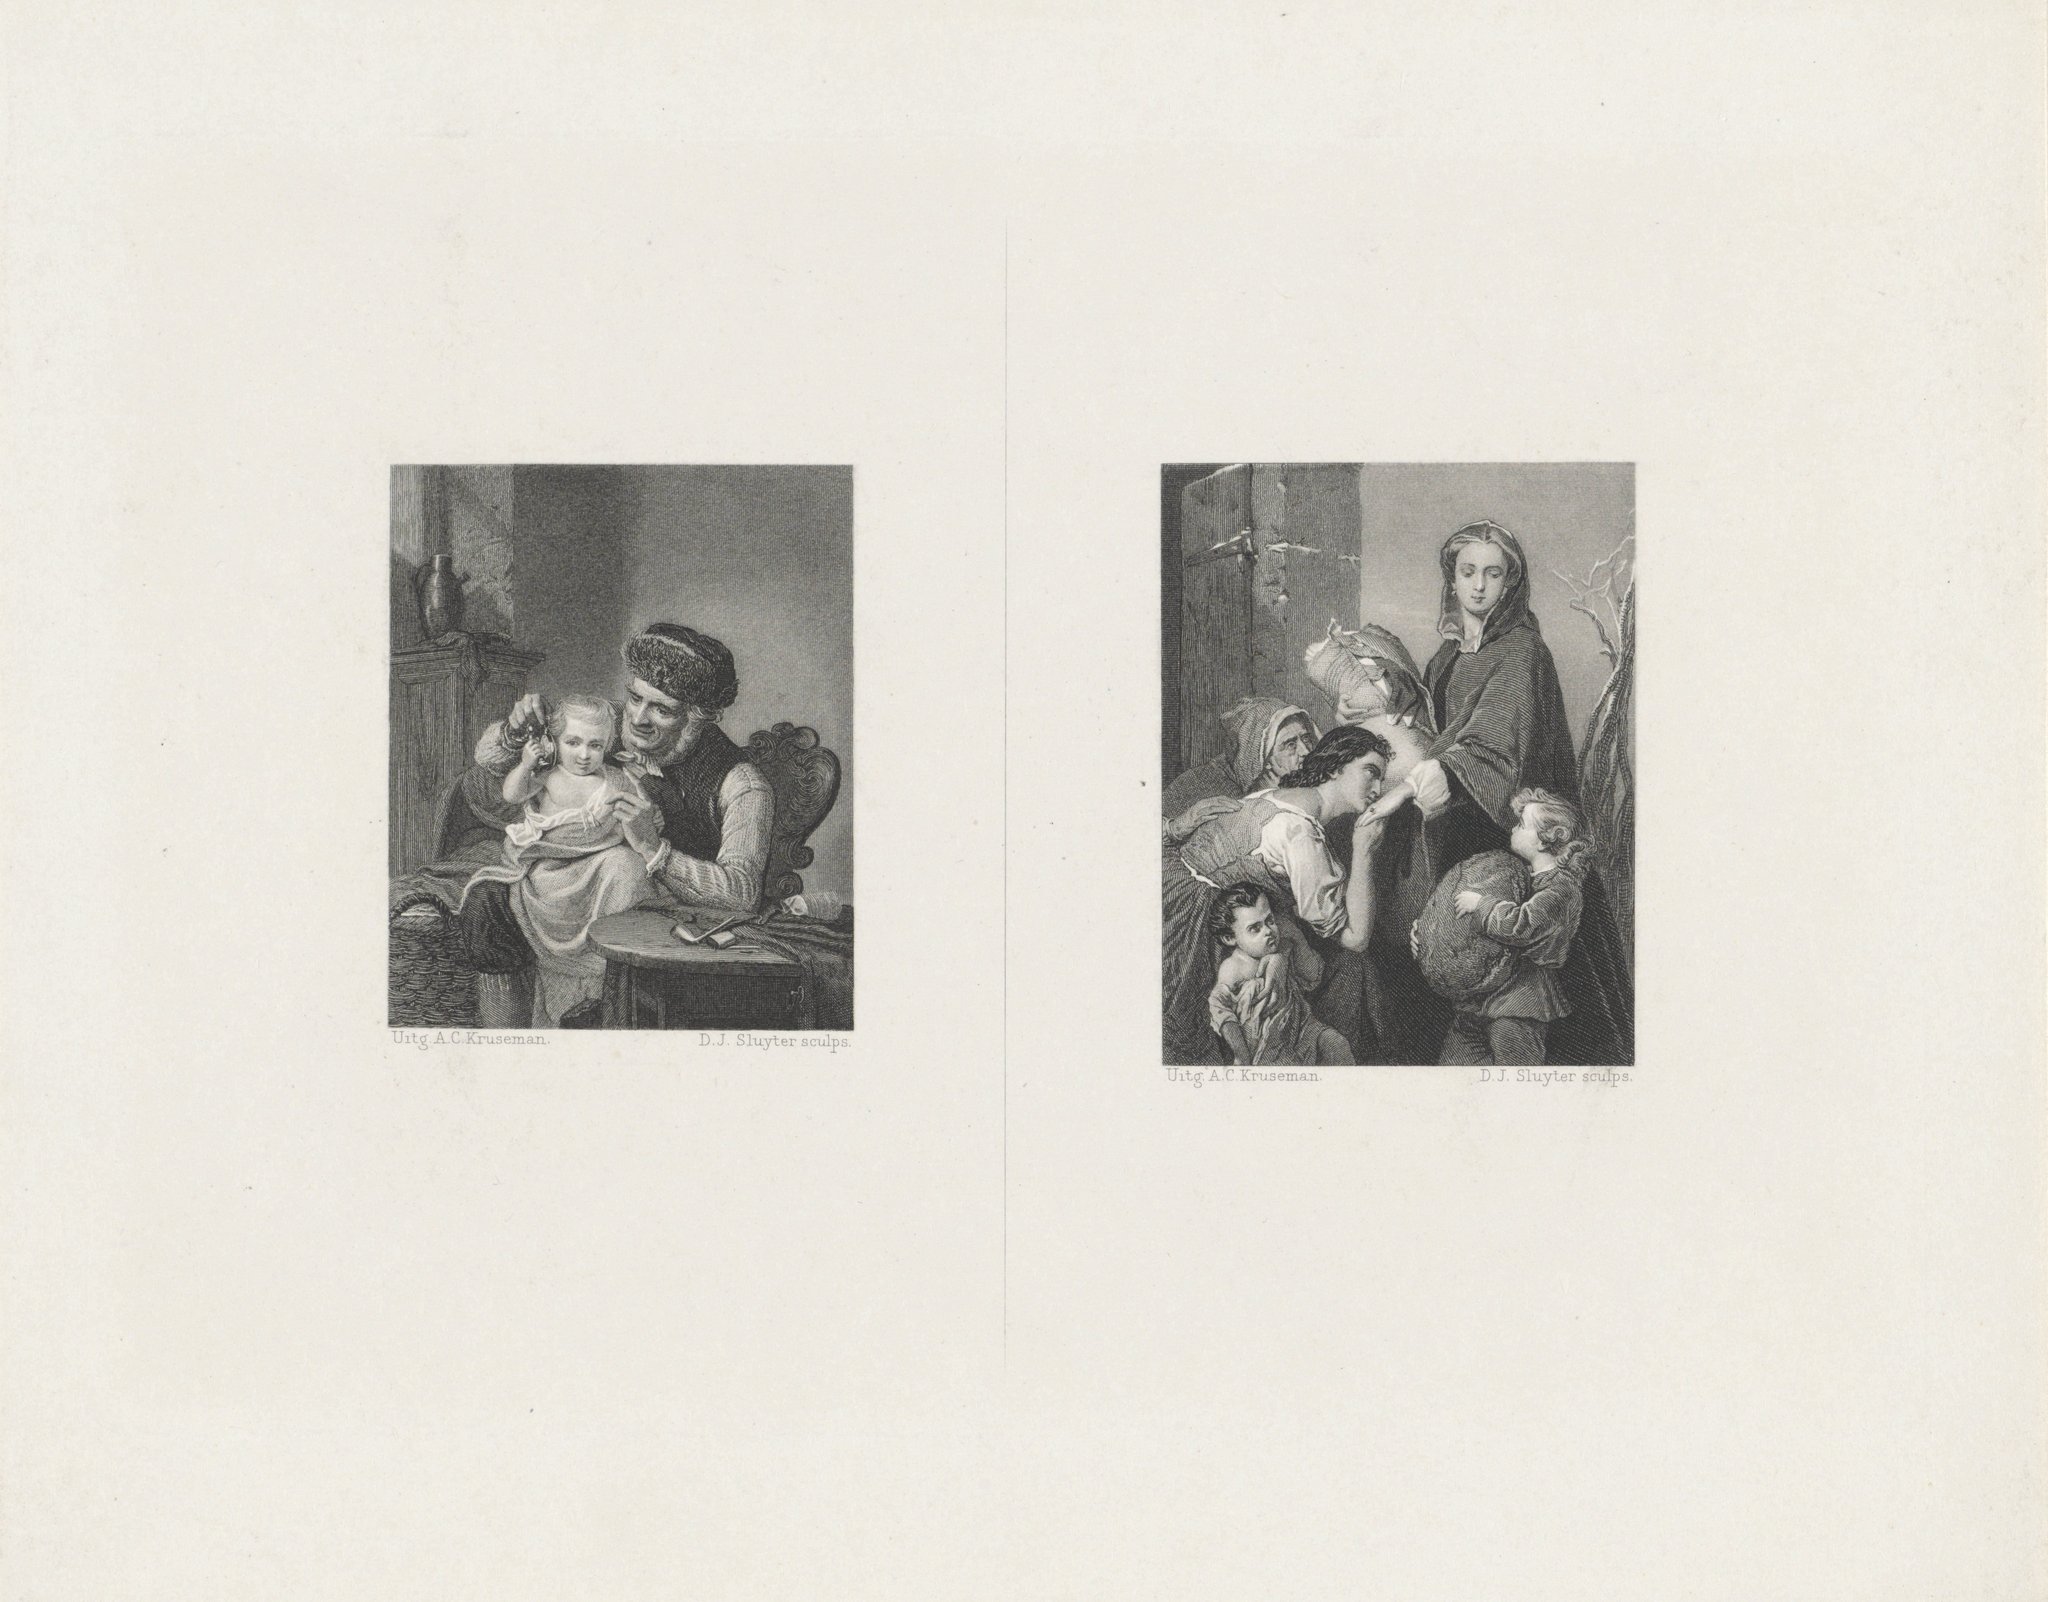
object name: book illustration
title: Oude man met kind - Weldoenster der armen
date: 1842-1873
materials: paper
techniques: aquatint, etching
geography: amsterdam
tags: giving alms or other charity, e.g.: handing out food, pipe ~ tobacco, grandparent(s) with grandchild(ren) (family group), watch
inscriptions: collector's mark: Lugt 2228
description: Twee boekillustraties op een plaat. Links een oude man, die een baby op zijn schoot het getik van zijn horloge laat horen. Het kind houdt een schaakstuk in de hand. Op tafel ligt een Goudse pijp. Rechts een rijkgeklede vrouw en haar zoontje met hun armen vol giften. Een in lompen geklede vrouw kust haar de hand. Met haar andere hand houdt de arme vrouw haar zoontje vast. Een oude vrouw kijkt om naar haar weldoenster.